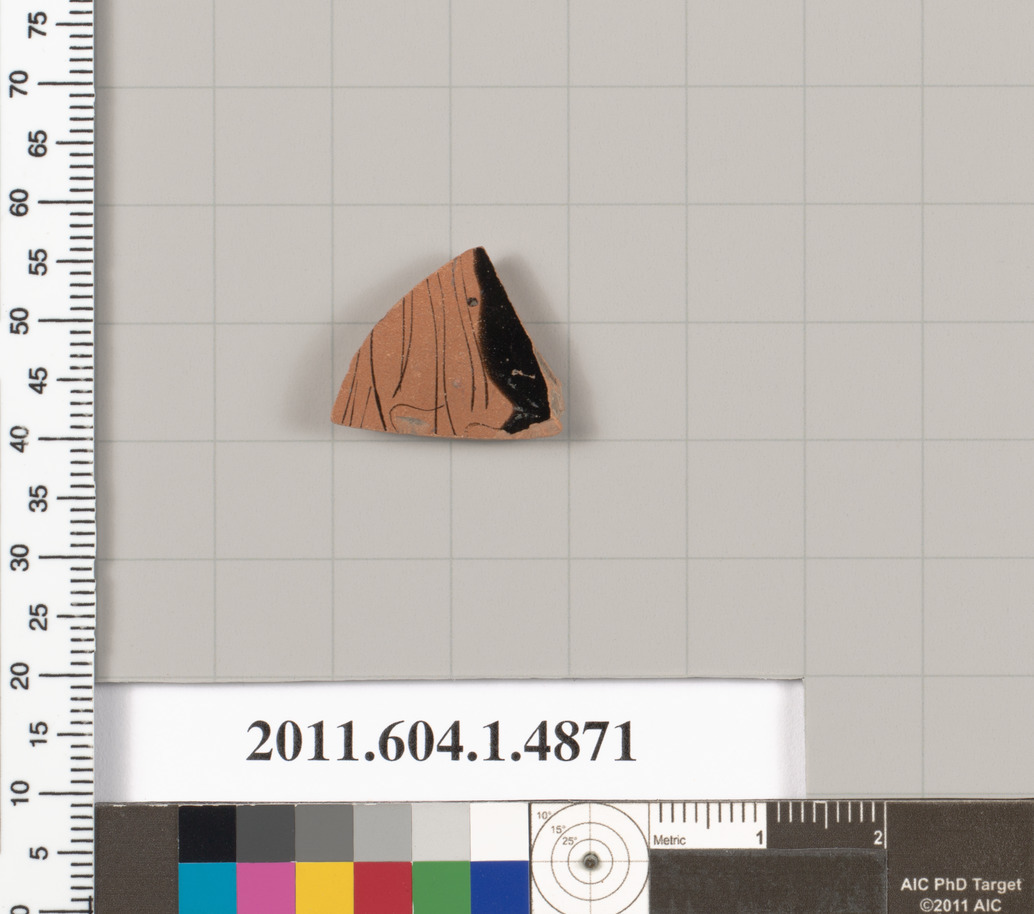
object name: kylix fragment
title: Terracotta fragment of a kylix (drinking cup)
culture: greek, attic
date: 475-451 BCE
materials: terracotta